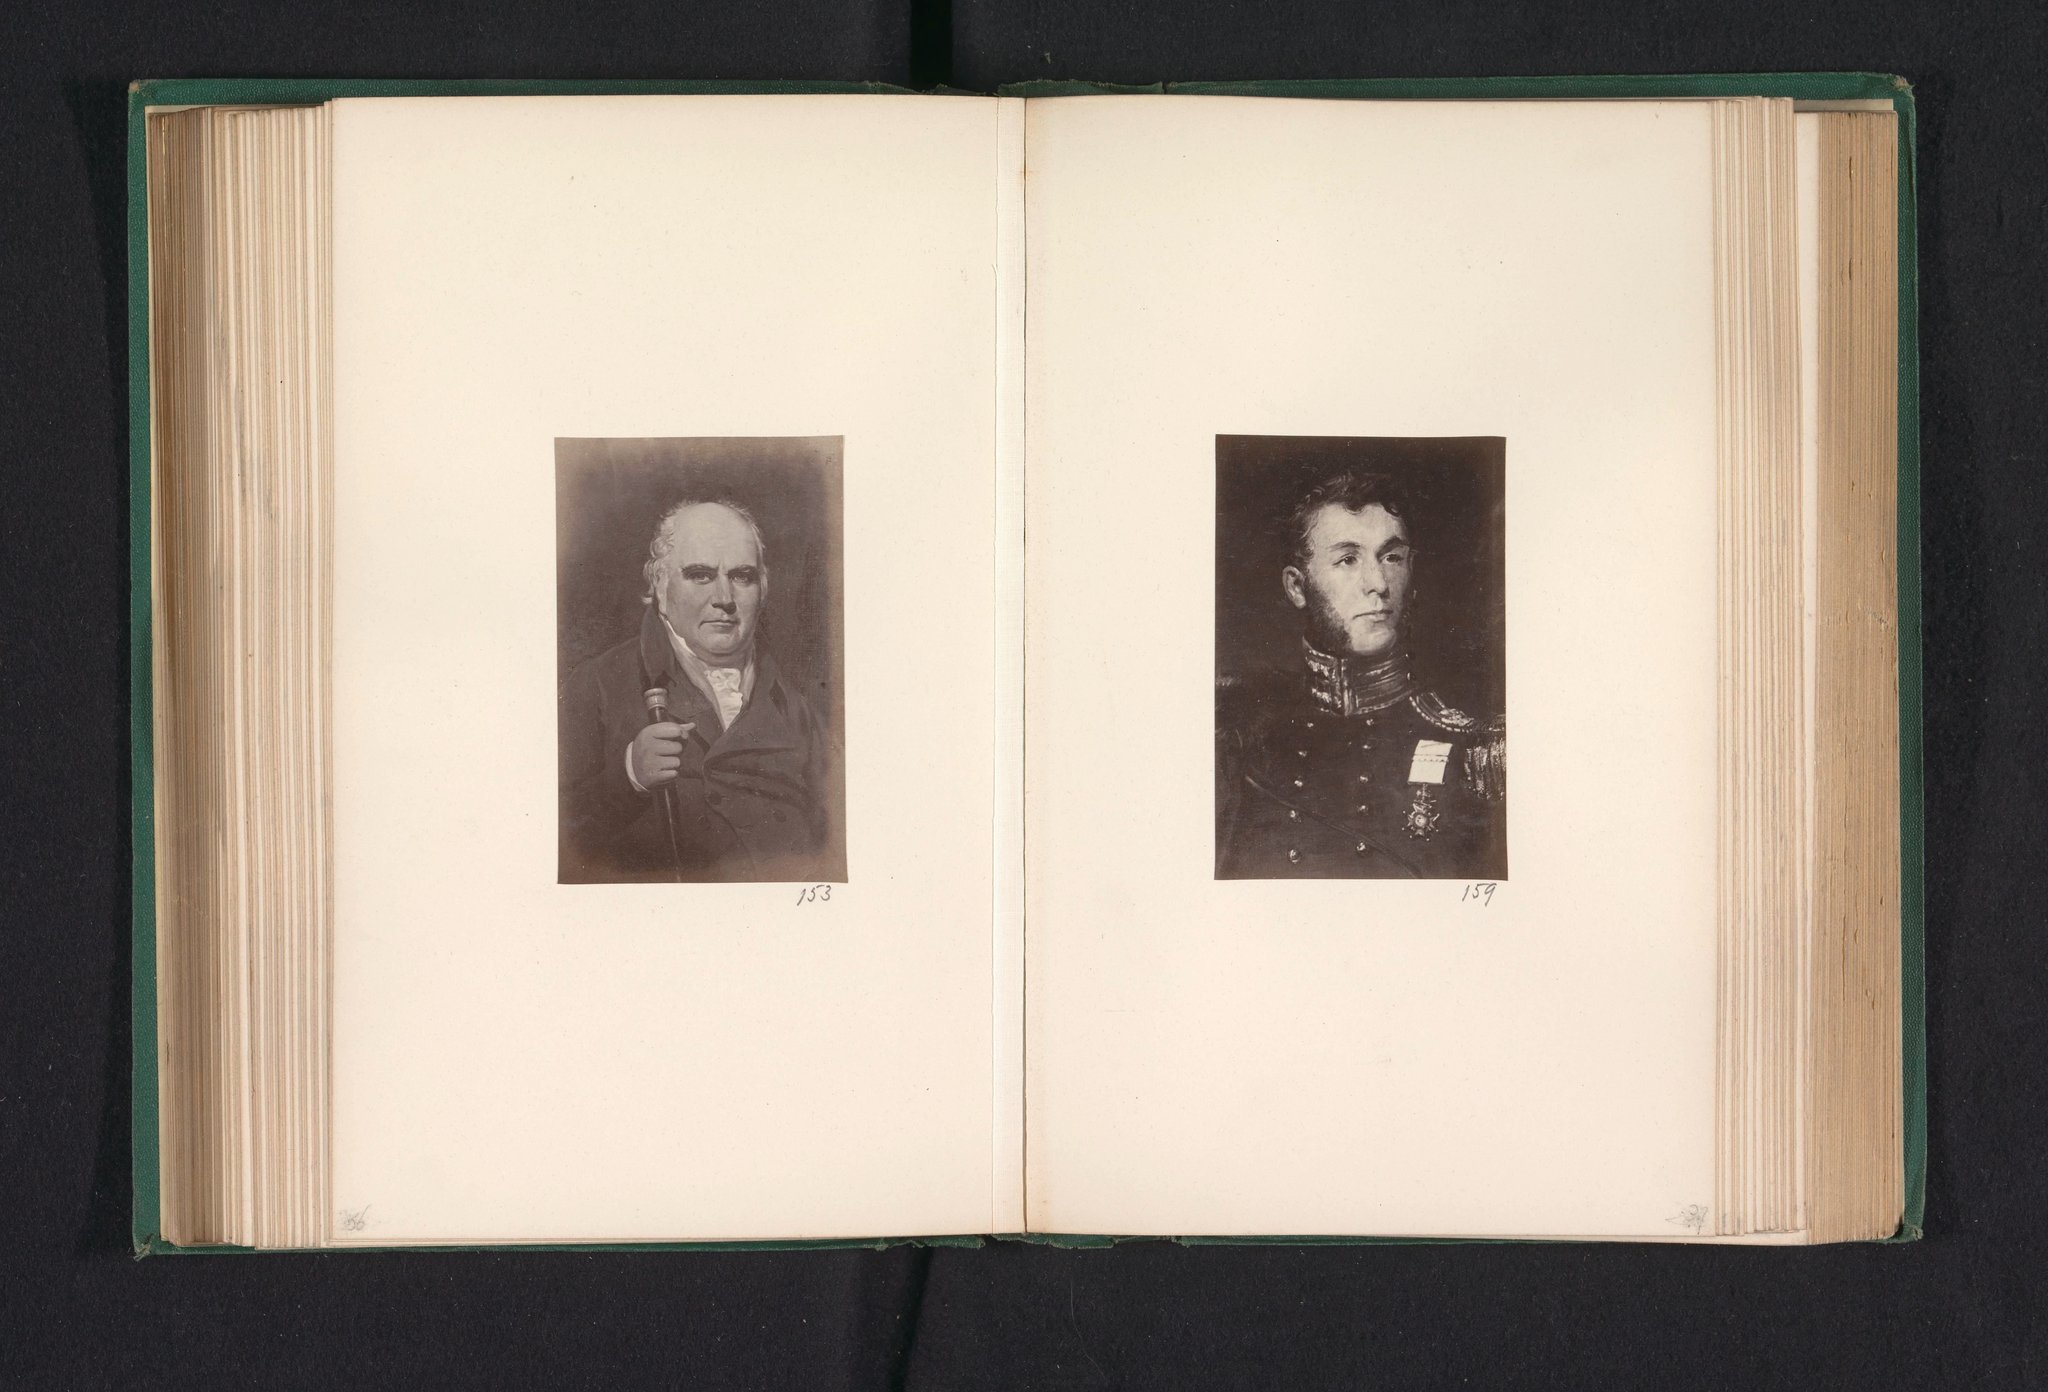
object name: reproduction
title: Fotoreproductie van een schilderij, voorstellende een portret van Alexander Hope Pattison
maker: thomas annan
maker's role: fotograaf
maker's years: 1829-1887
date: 1863-1868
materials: photographic support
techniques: albumen print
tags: historical persons (portraits and scenes from the life) (+ (full) bust portrait)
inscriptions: number: ‘159’